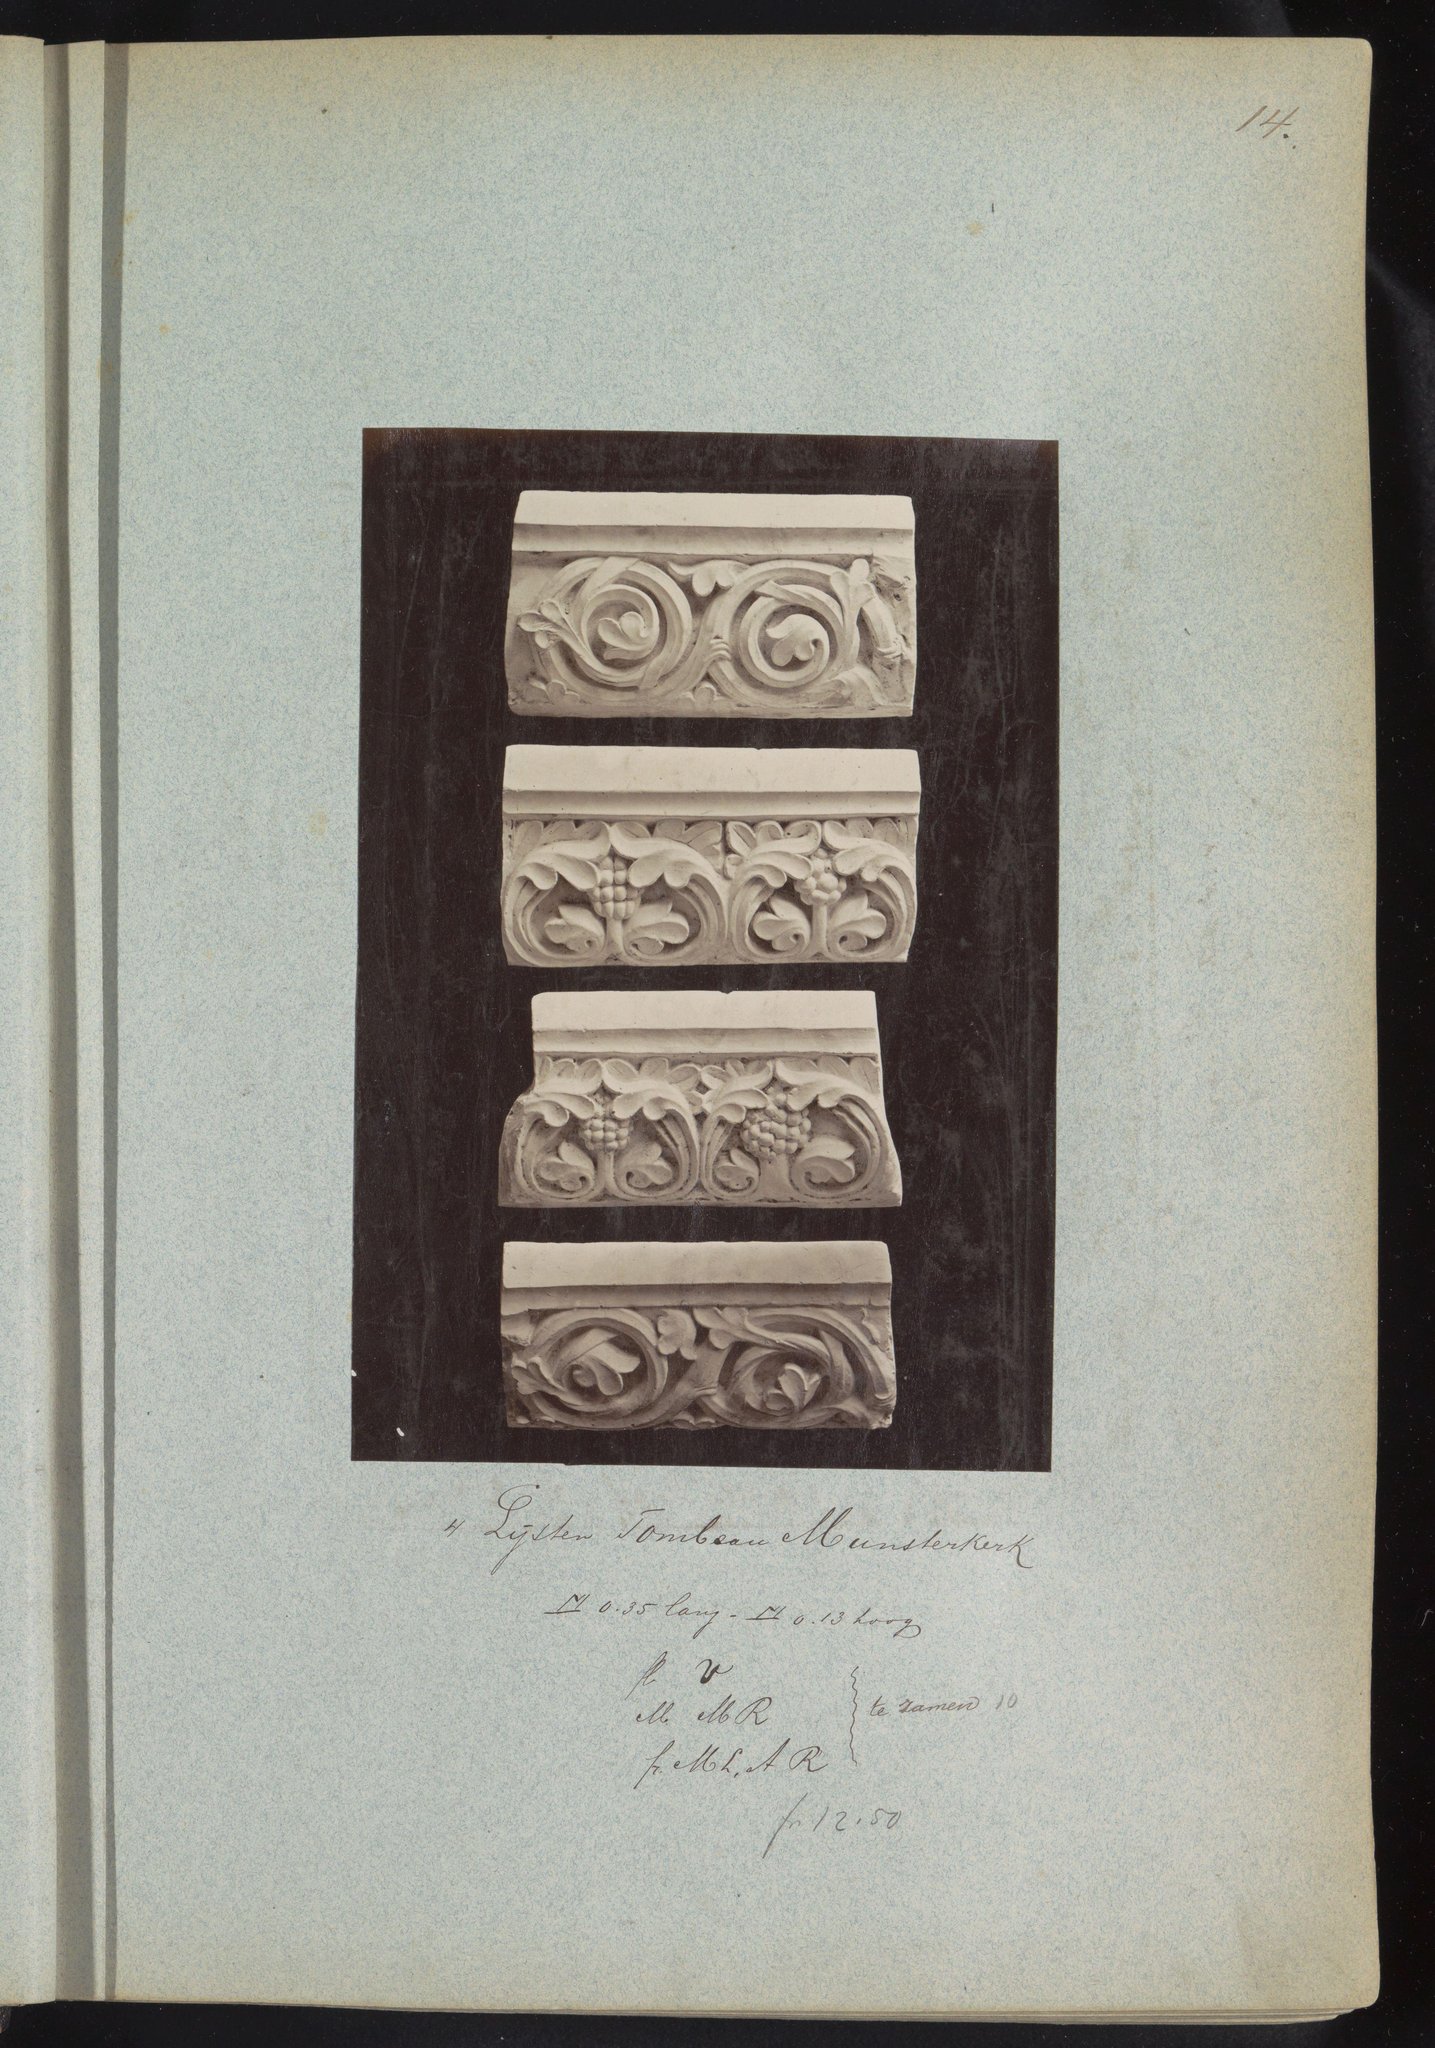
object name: album leaf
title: Vier gipsen afgietsels van lijsten van tombe in de Munsterkerk te Roermond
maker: Anonymous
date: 1875-1900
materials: paper, photographic support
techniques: albumen print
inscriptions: annotation: ‘4 lijsten Tombeau Munsterkerk / M 0.35 lang M 0.13 hoog’, annotation